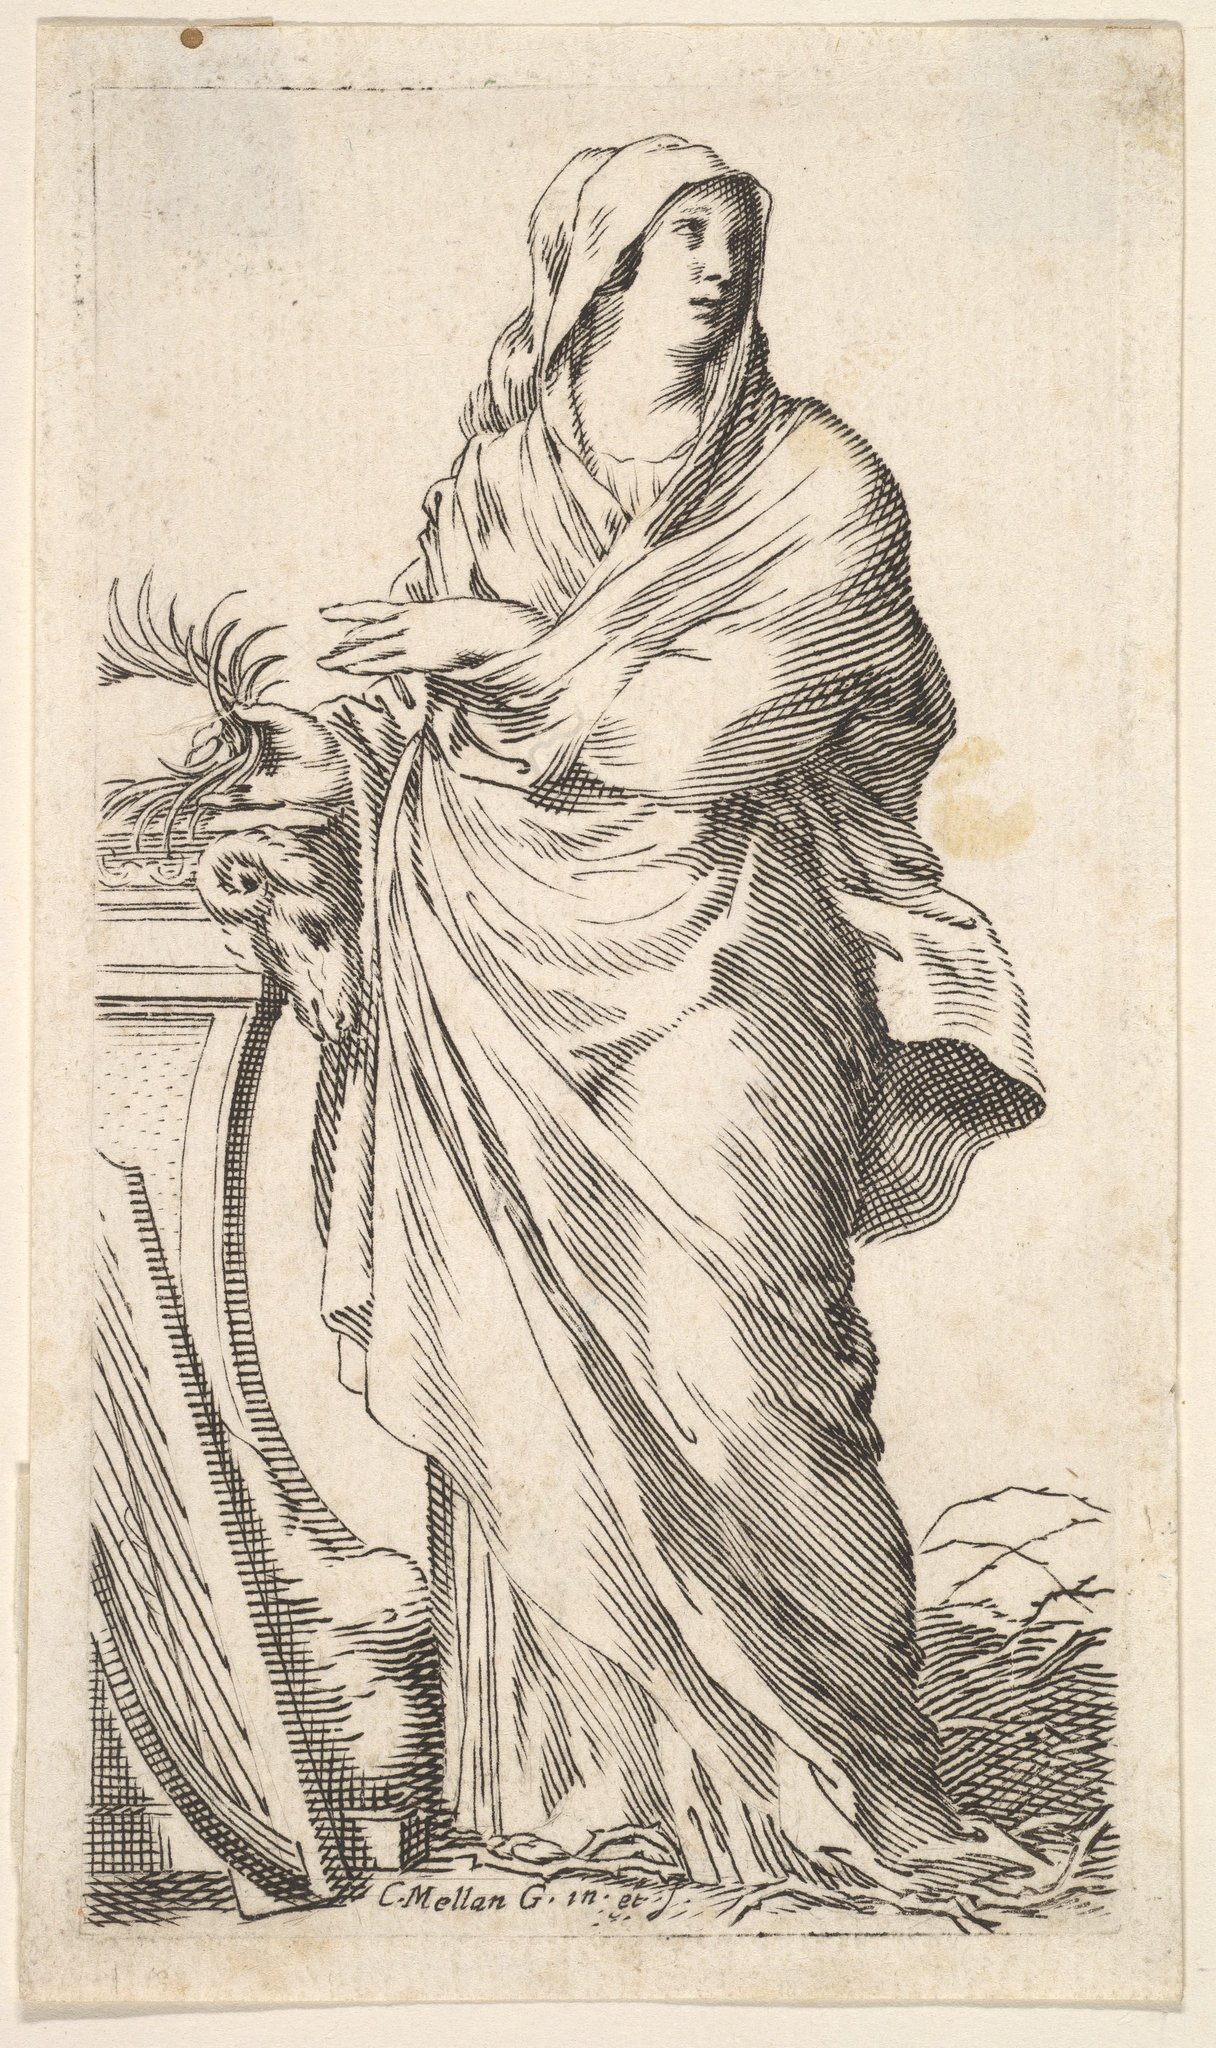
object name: print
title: Robed woman standing next to a plinth, her right hand bears a palm branch, a harp rests against the plinth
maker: claude mellan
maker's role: artist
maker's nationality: french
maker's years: 1598-1688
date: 1620-1688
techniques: engraving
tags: women,palms